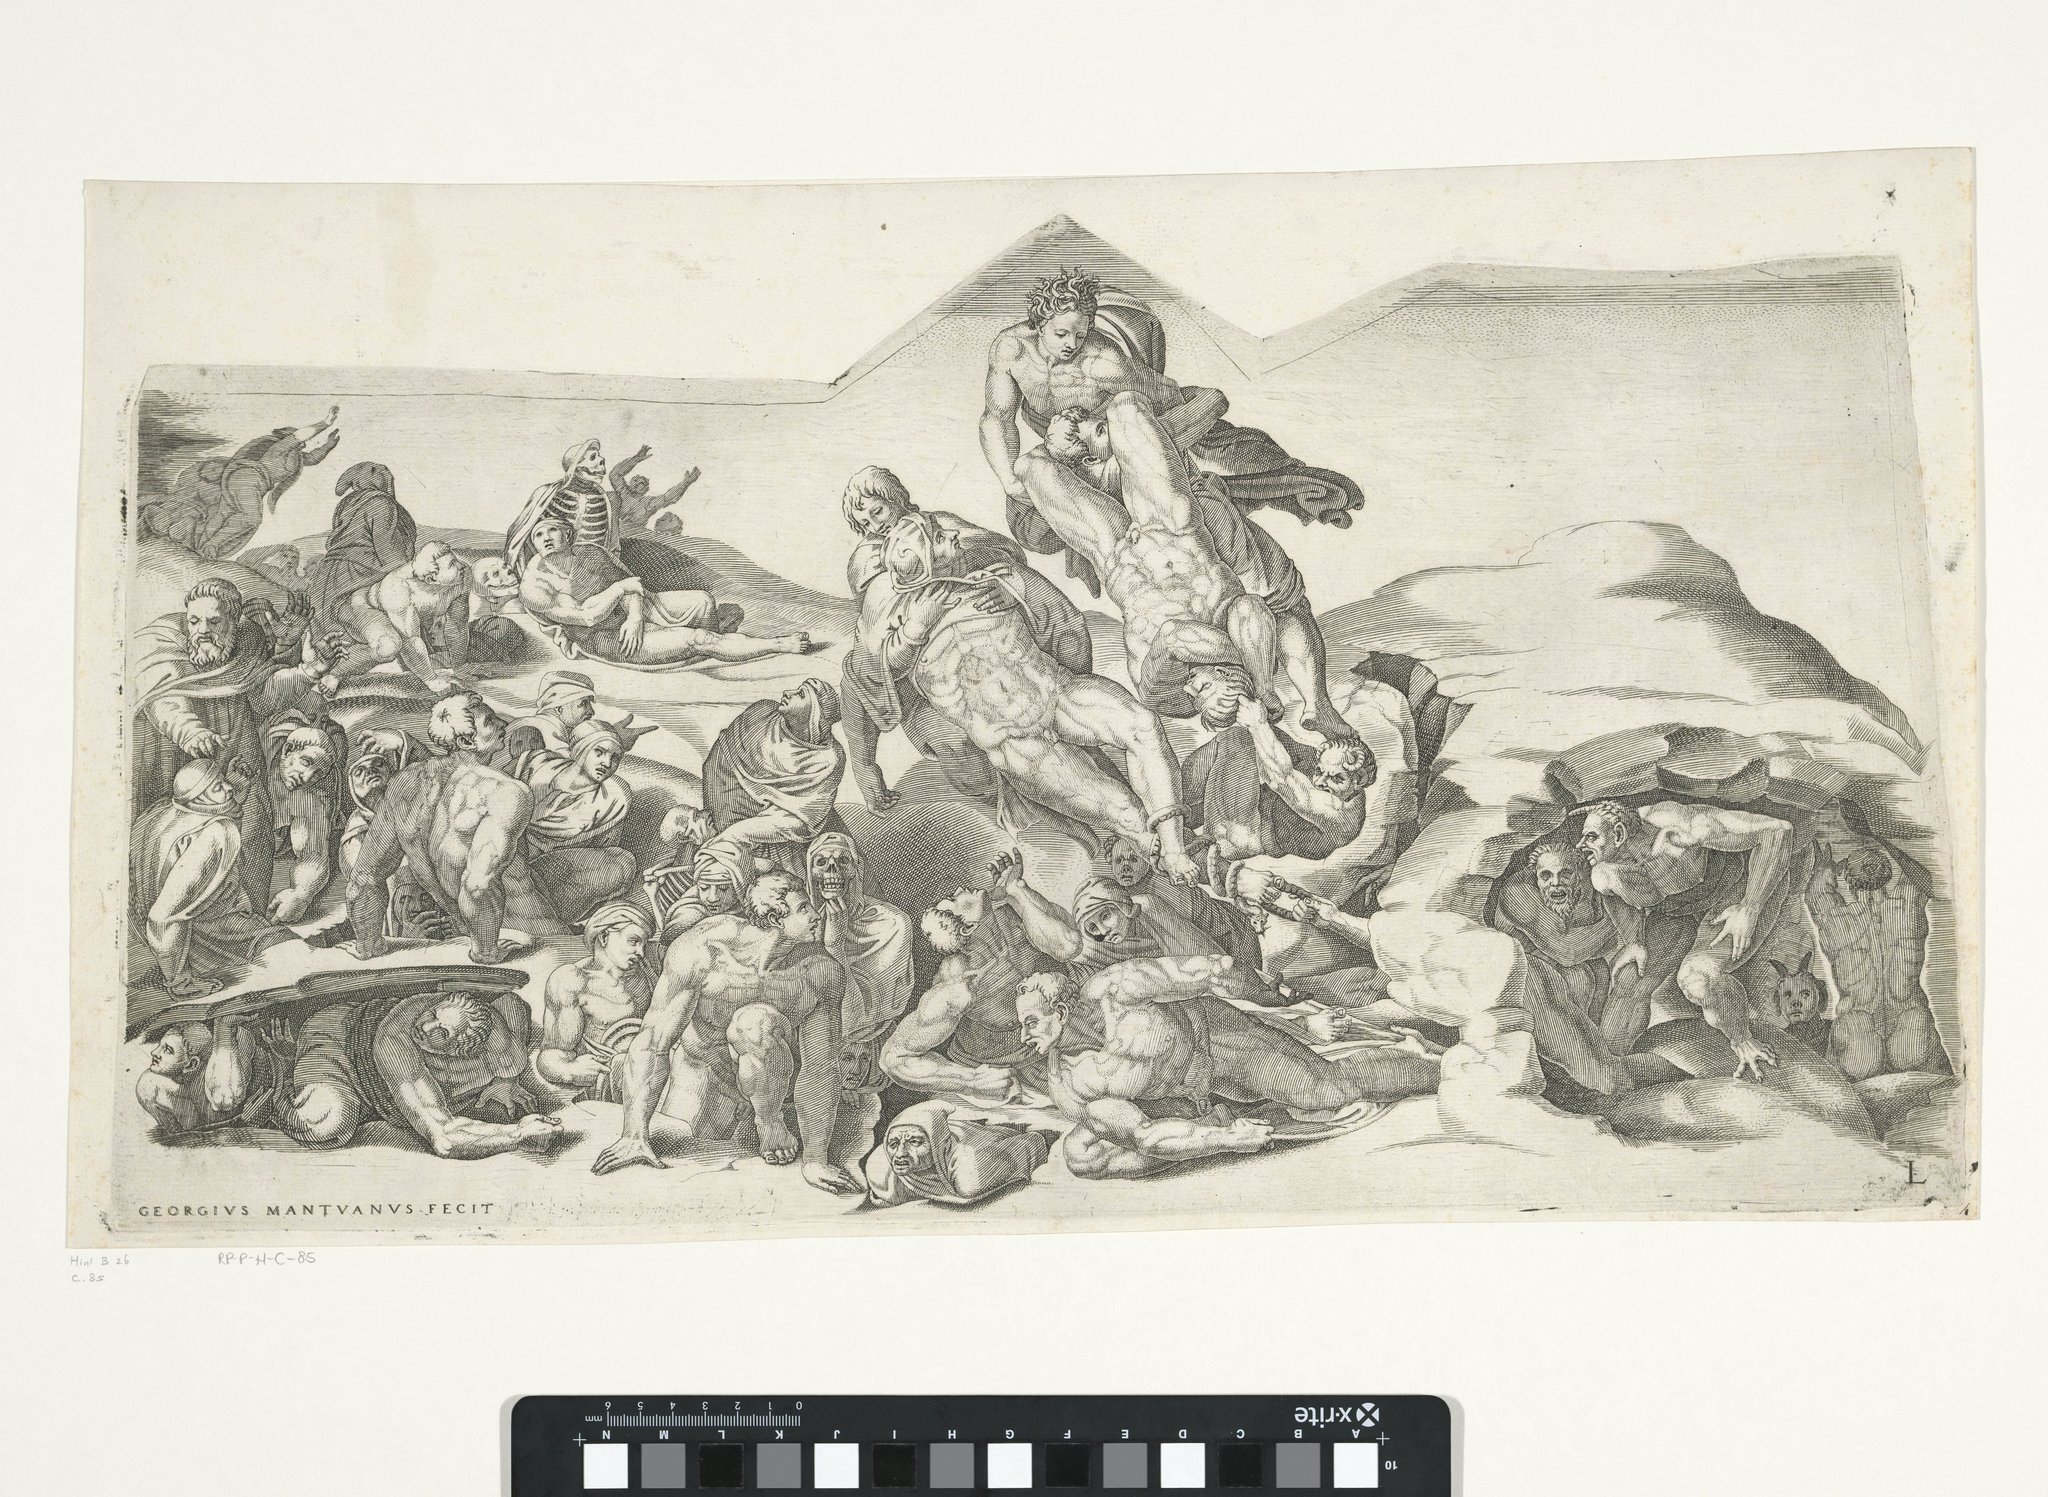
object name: print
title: Het laatste oordeel, blad L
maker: giorgio ghisi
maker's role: print maker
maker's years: 1520-1582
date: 1530-1582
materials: paper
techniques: engraving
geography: vatican city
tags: last judgement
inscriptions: collector's mark: ‘Hinloopen’, number: ‘4’, collector's mark: Lugt 11, collector's mark: Lugt 10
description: Prent maakt deel uit van een groep van tien prenten die samen één grote voorstelling vormen naar het fresco met het Laatste Oordeel door Michelangelo in de Sixtijnse Kapel in het Vaticaan.